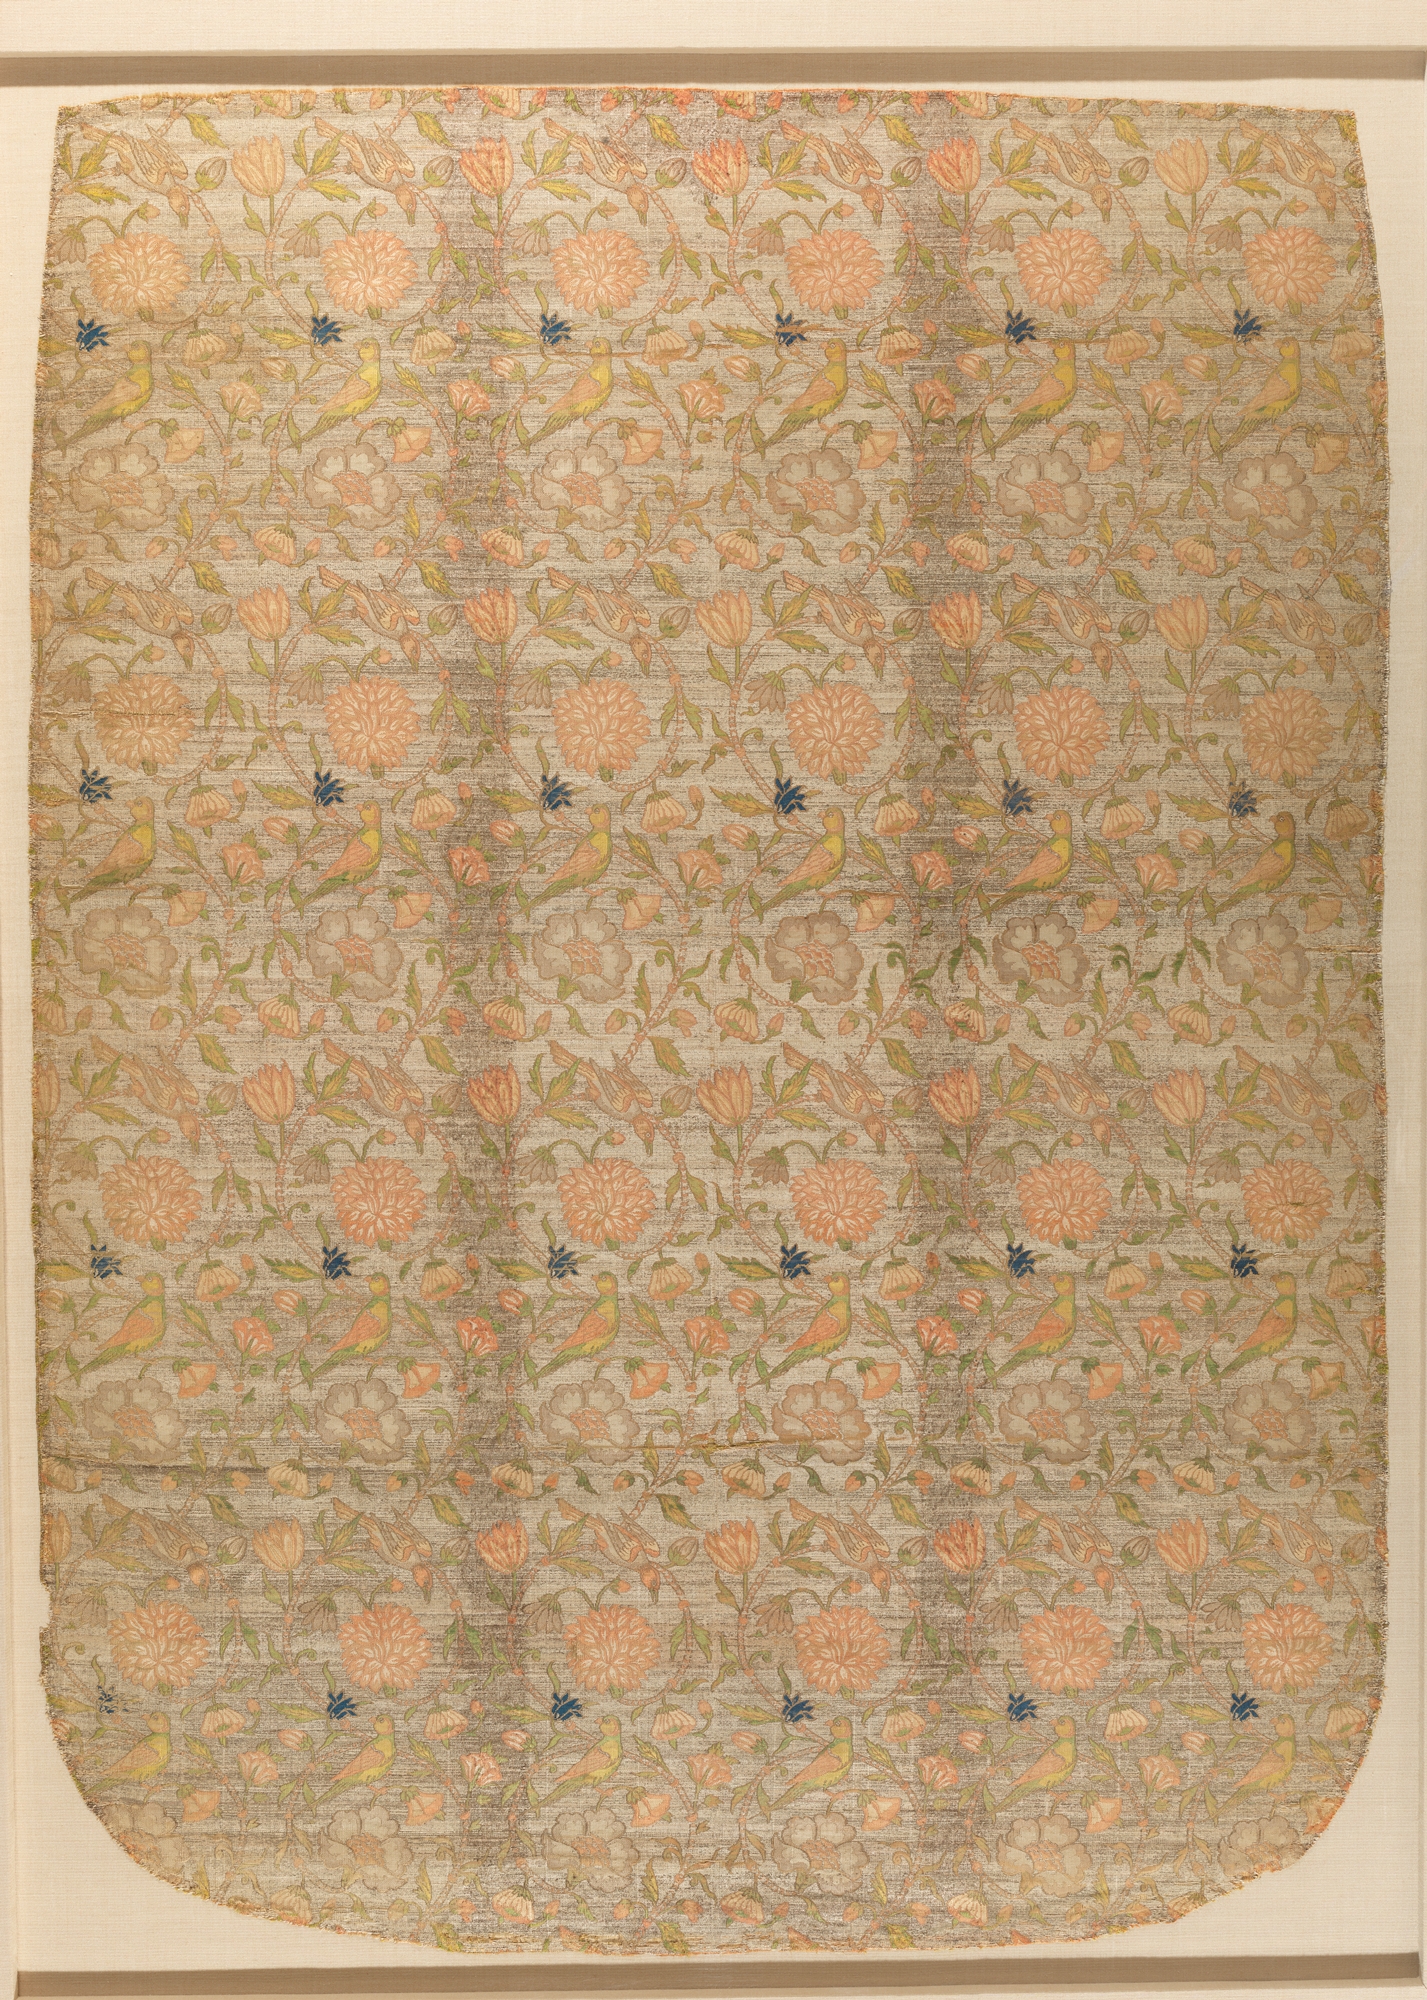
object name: textile panel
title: Textile Panel with Birds amid Flowering Vines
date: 1601-1650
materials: metal thread, silk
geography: iran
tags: birds,flowers